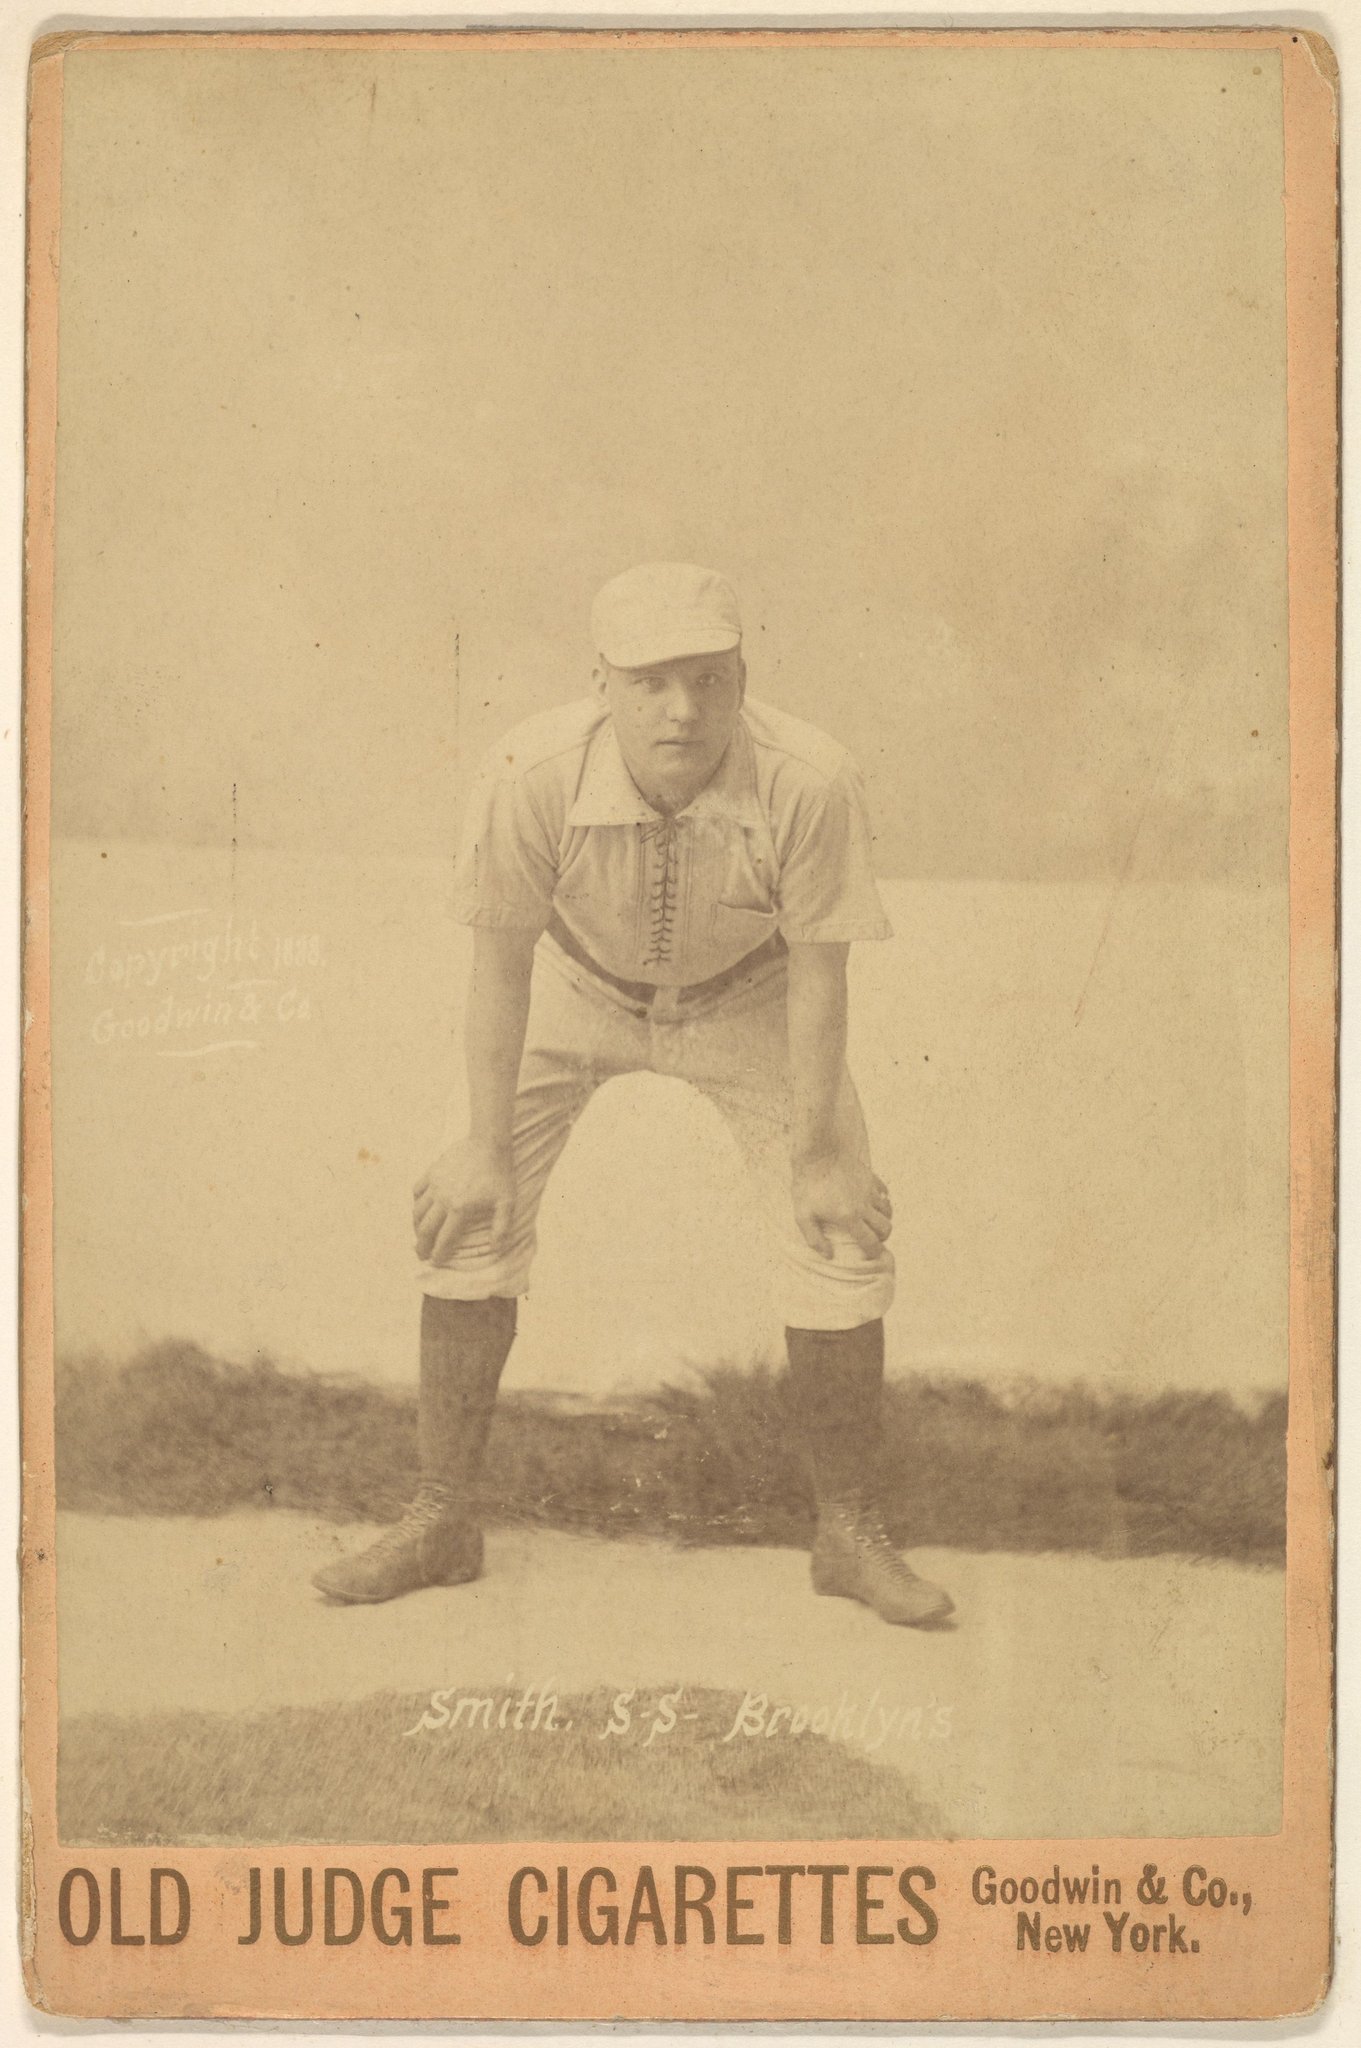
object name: baseball card, photograph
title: Smith, Shortstop, Brooklyn, from the series Old Judge Cigarettes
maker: goodwin & company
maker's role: publisher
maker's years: 1850-1950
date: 1888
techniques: albumen silver print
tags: men,portraits,baseball,athletes